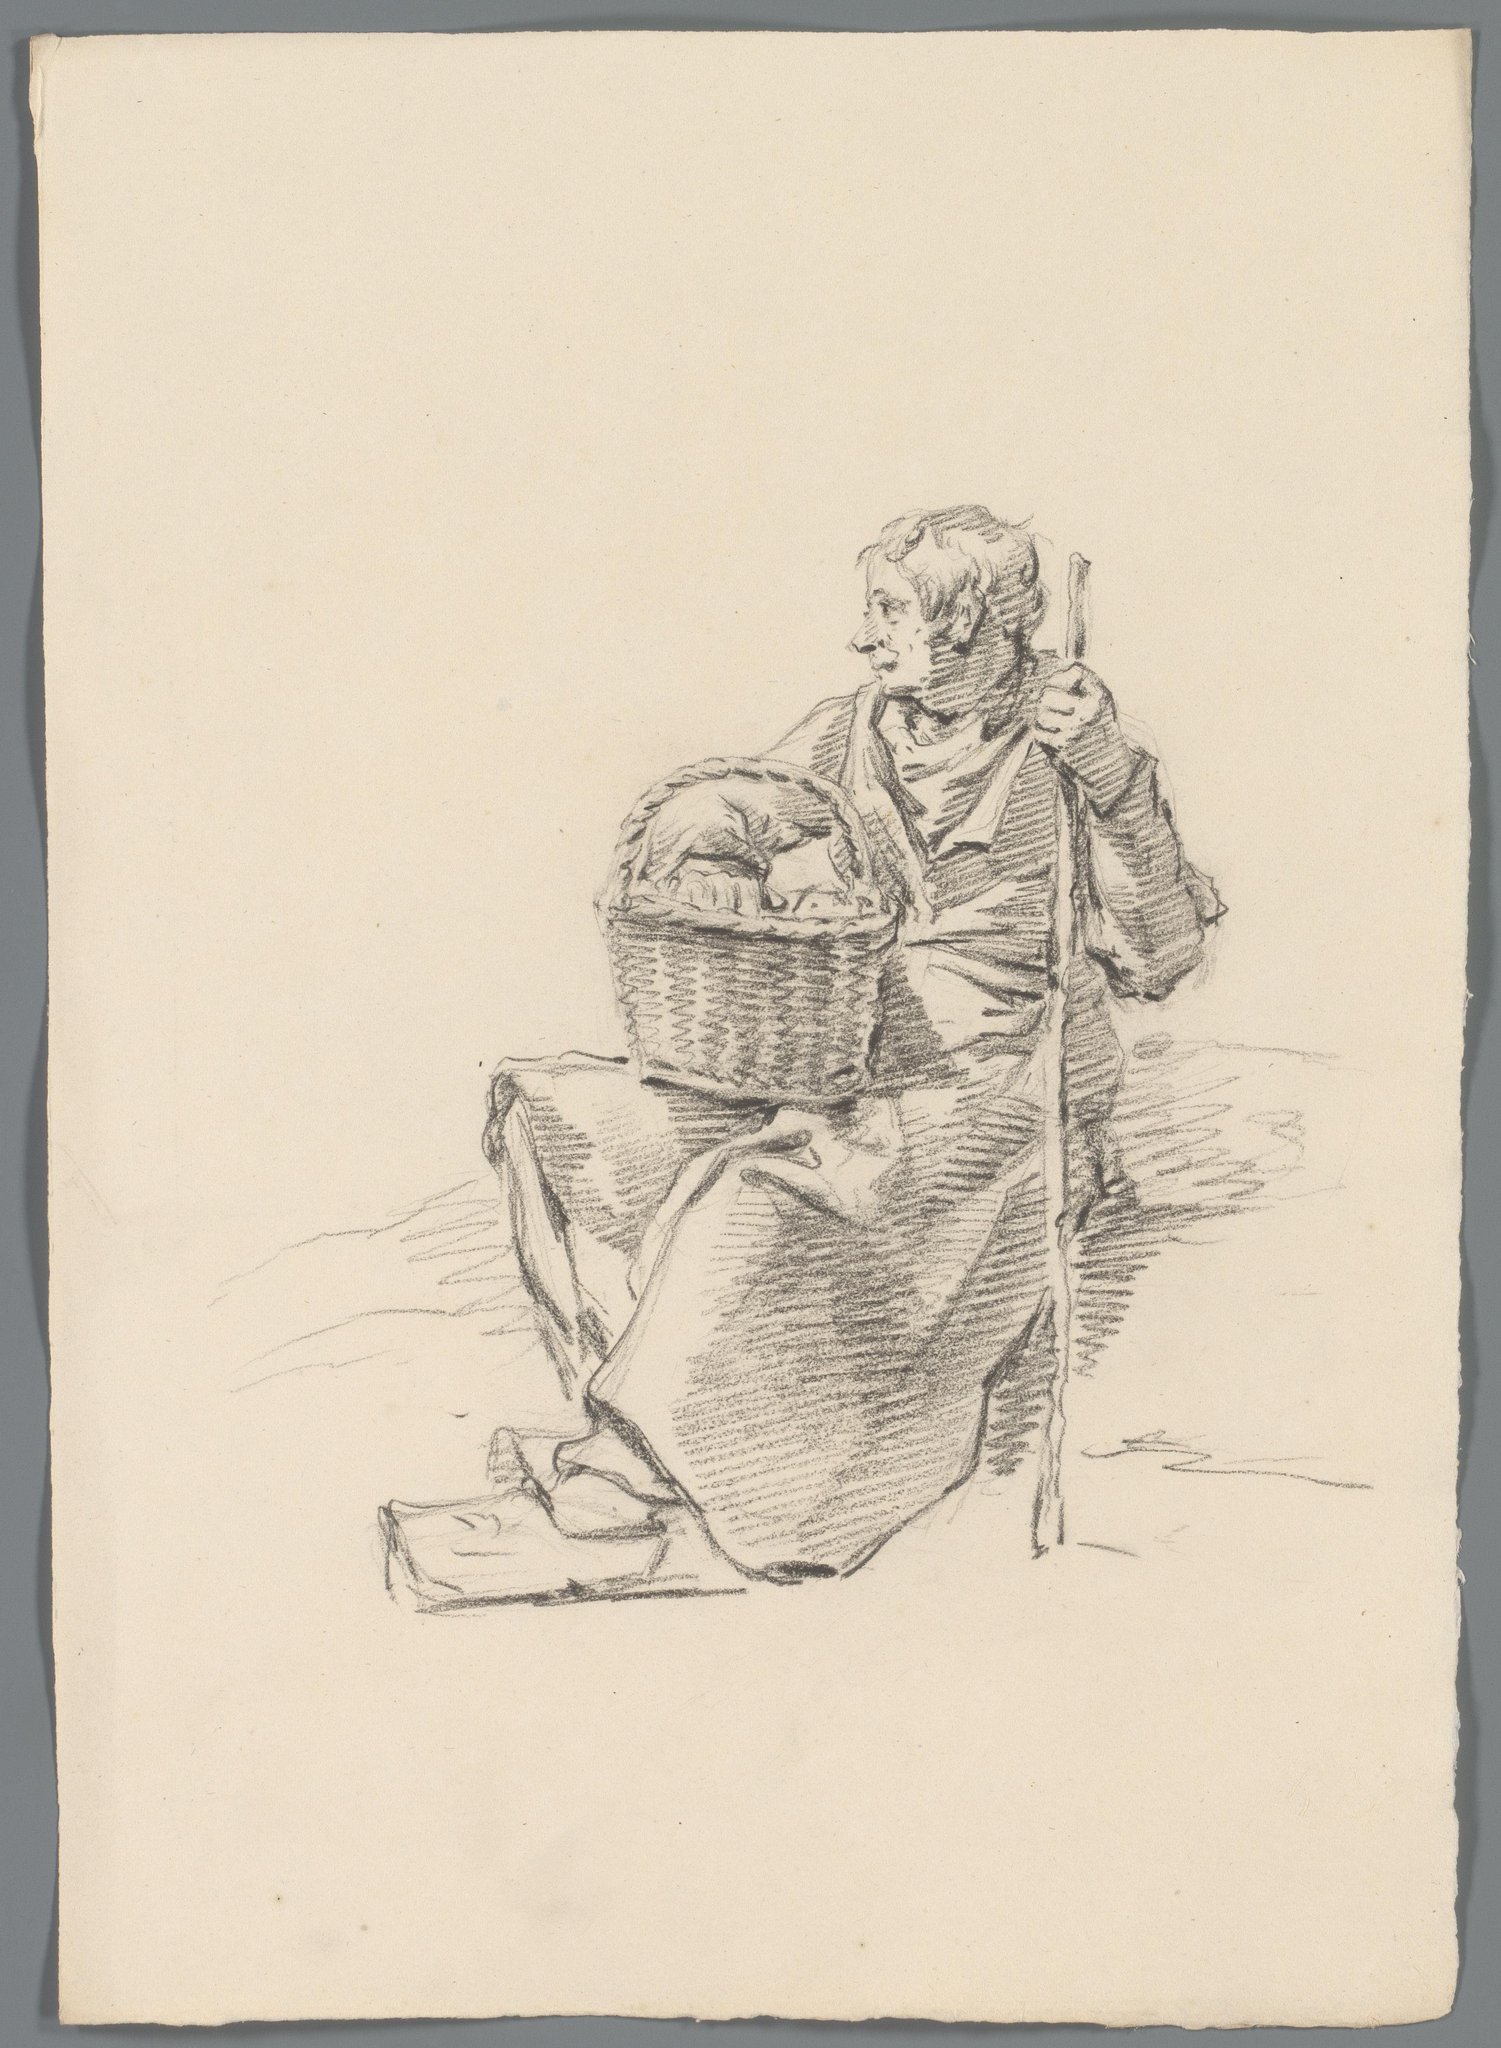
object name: drawing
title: Man met een mand en stok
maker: Anonymous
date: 1820-1830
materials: chalk, paper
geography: the hague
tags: walking-stick, staff, wooden shoes, clogs, adult man, container made of plant material other than wood: basket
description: Tekeningen waarschijnlijk ontstaan bij het Haagse kunstgenootschap ‘Tot Nut der Tekenkunst’, waar twee keer per week tekenavonden werden georganiseerd met geklede modellen.